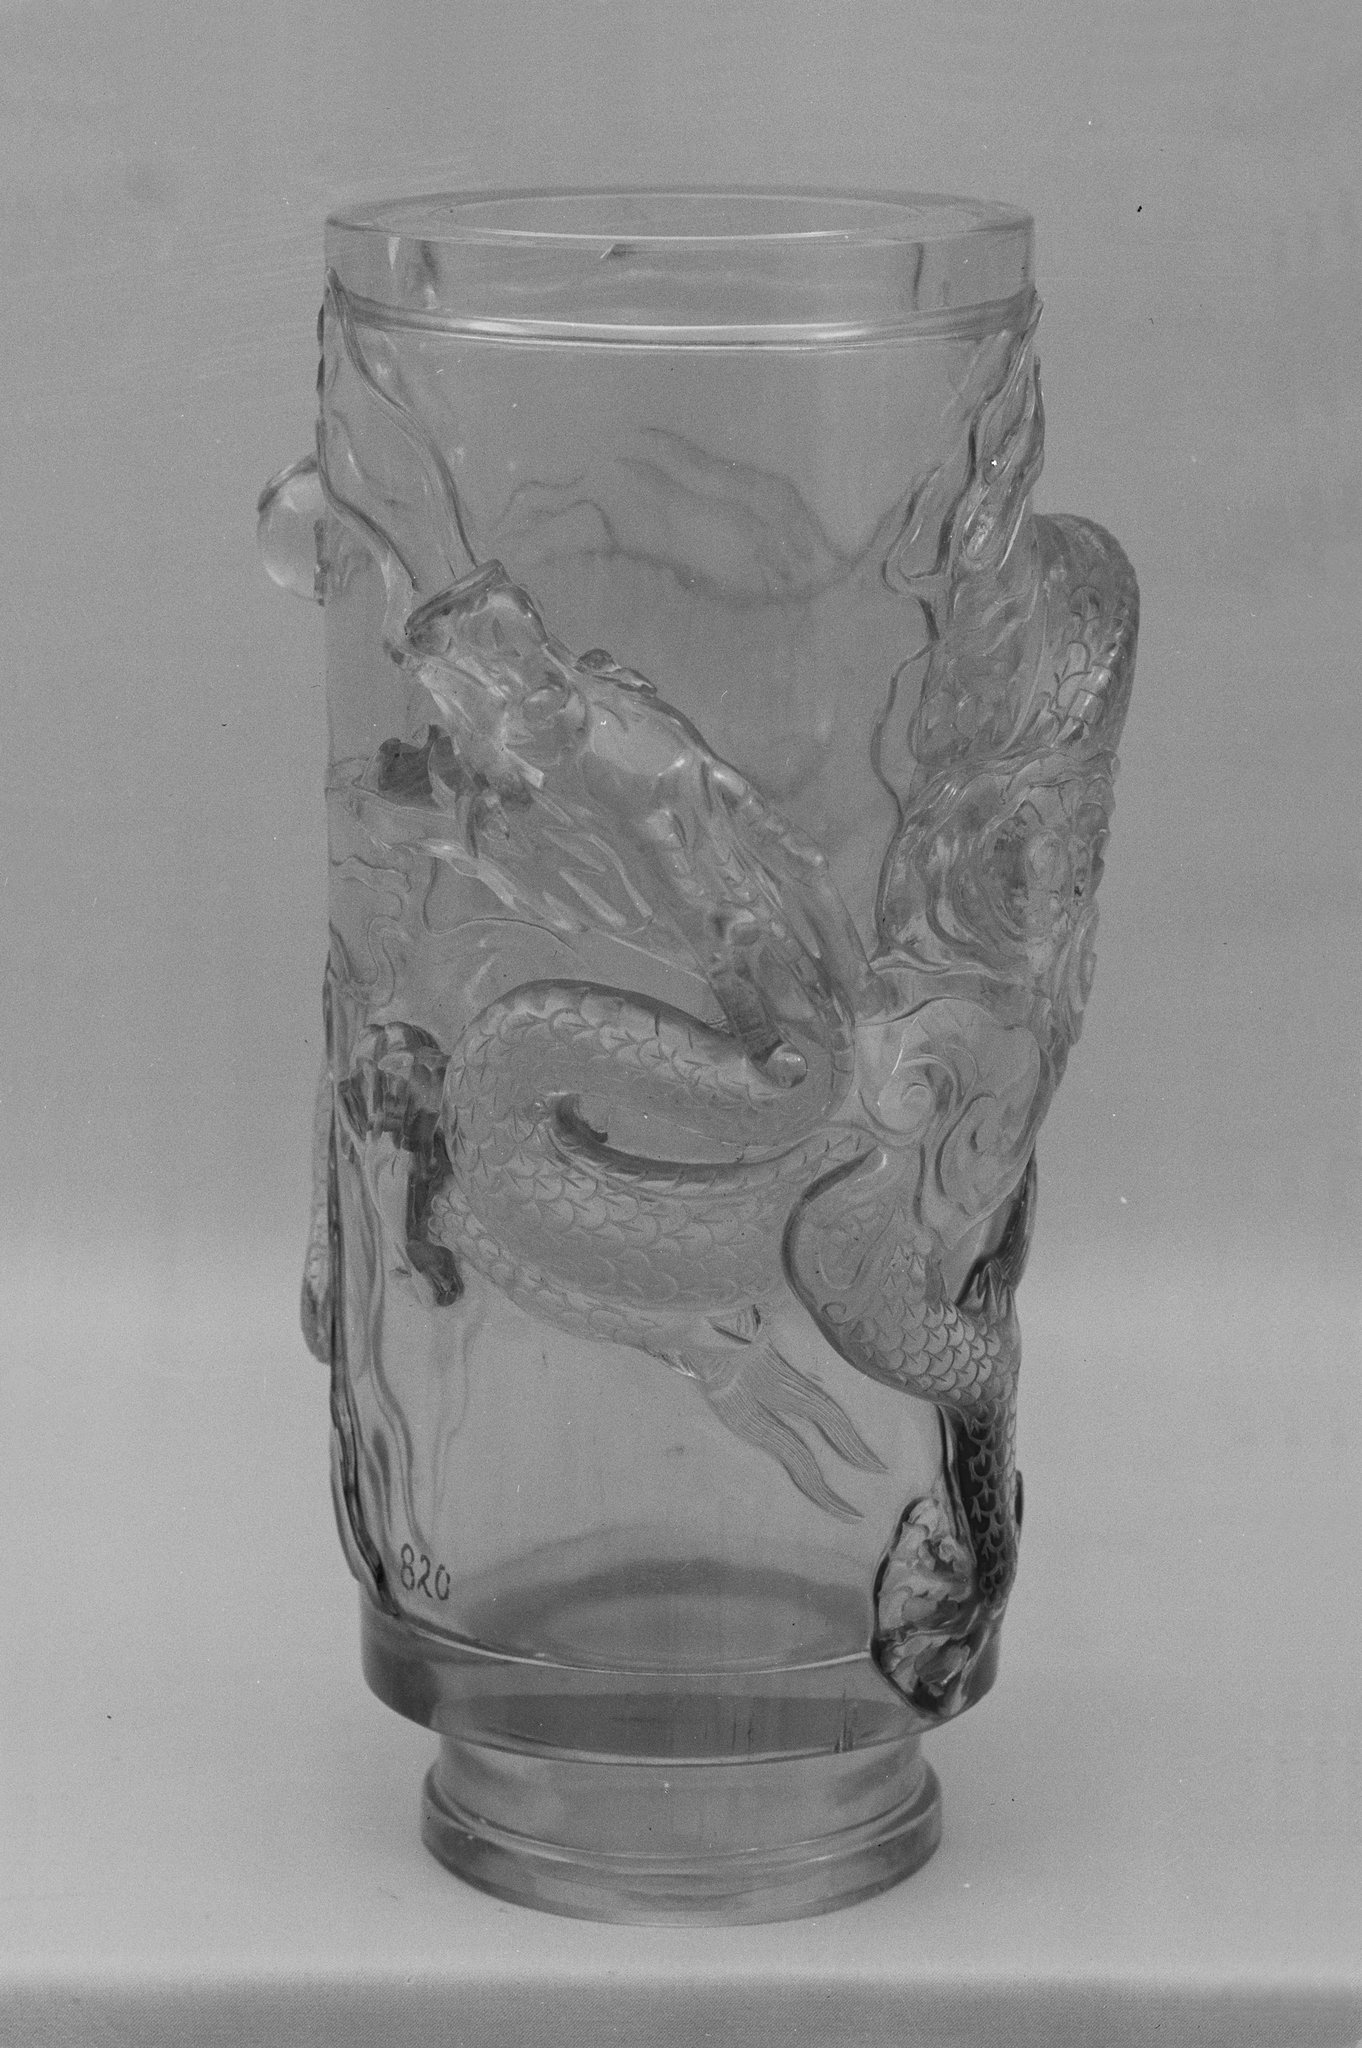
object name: vase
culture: chinese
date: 1701-1800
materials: quartz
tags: dragons